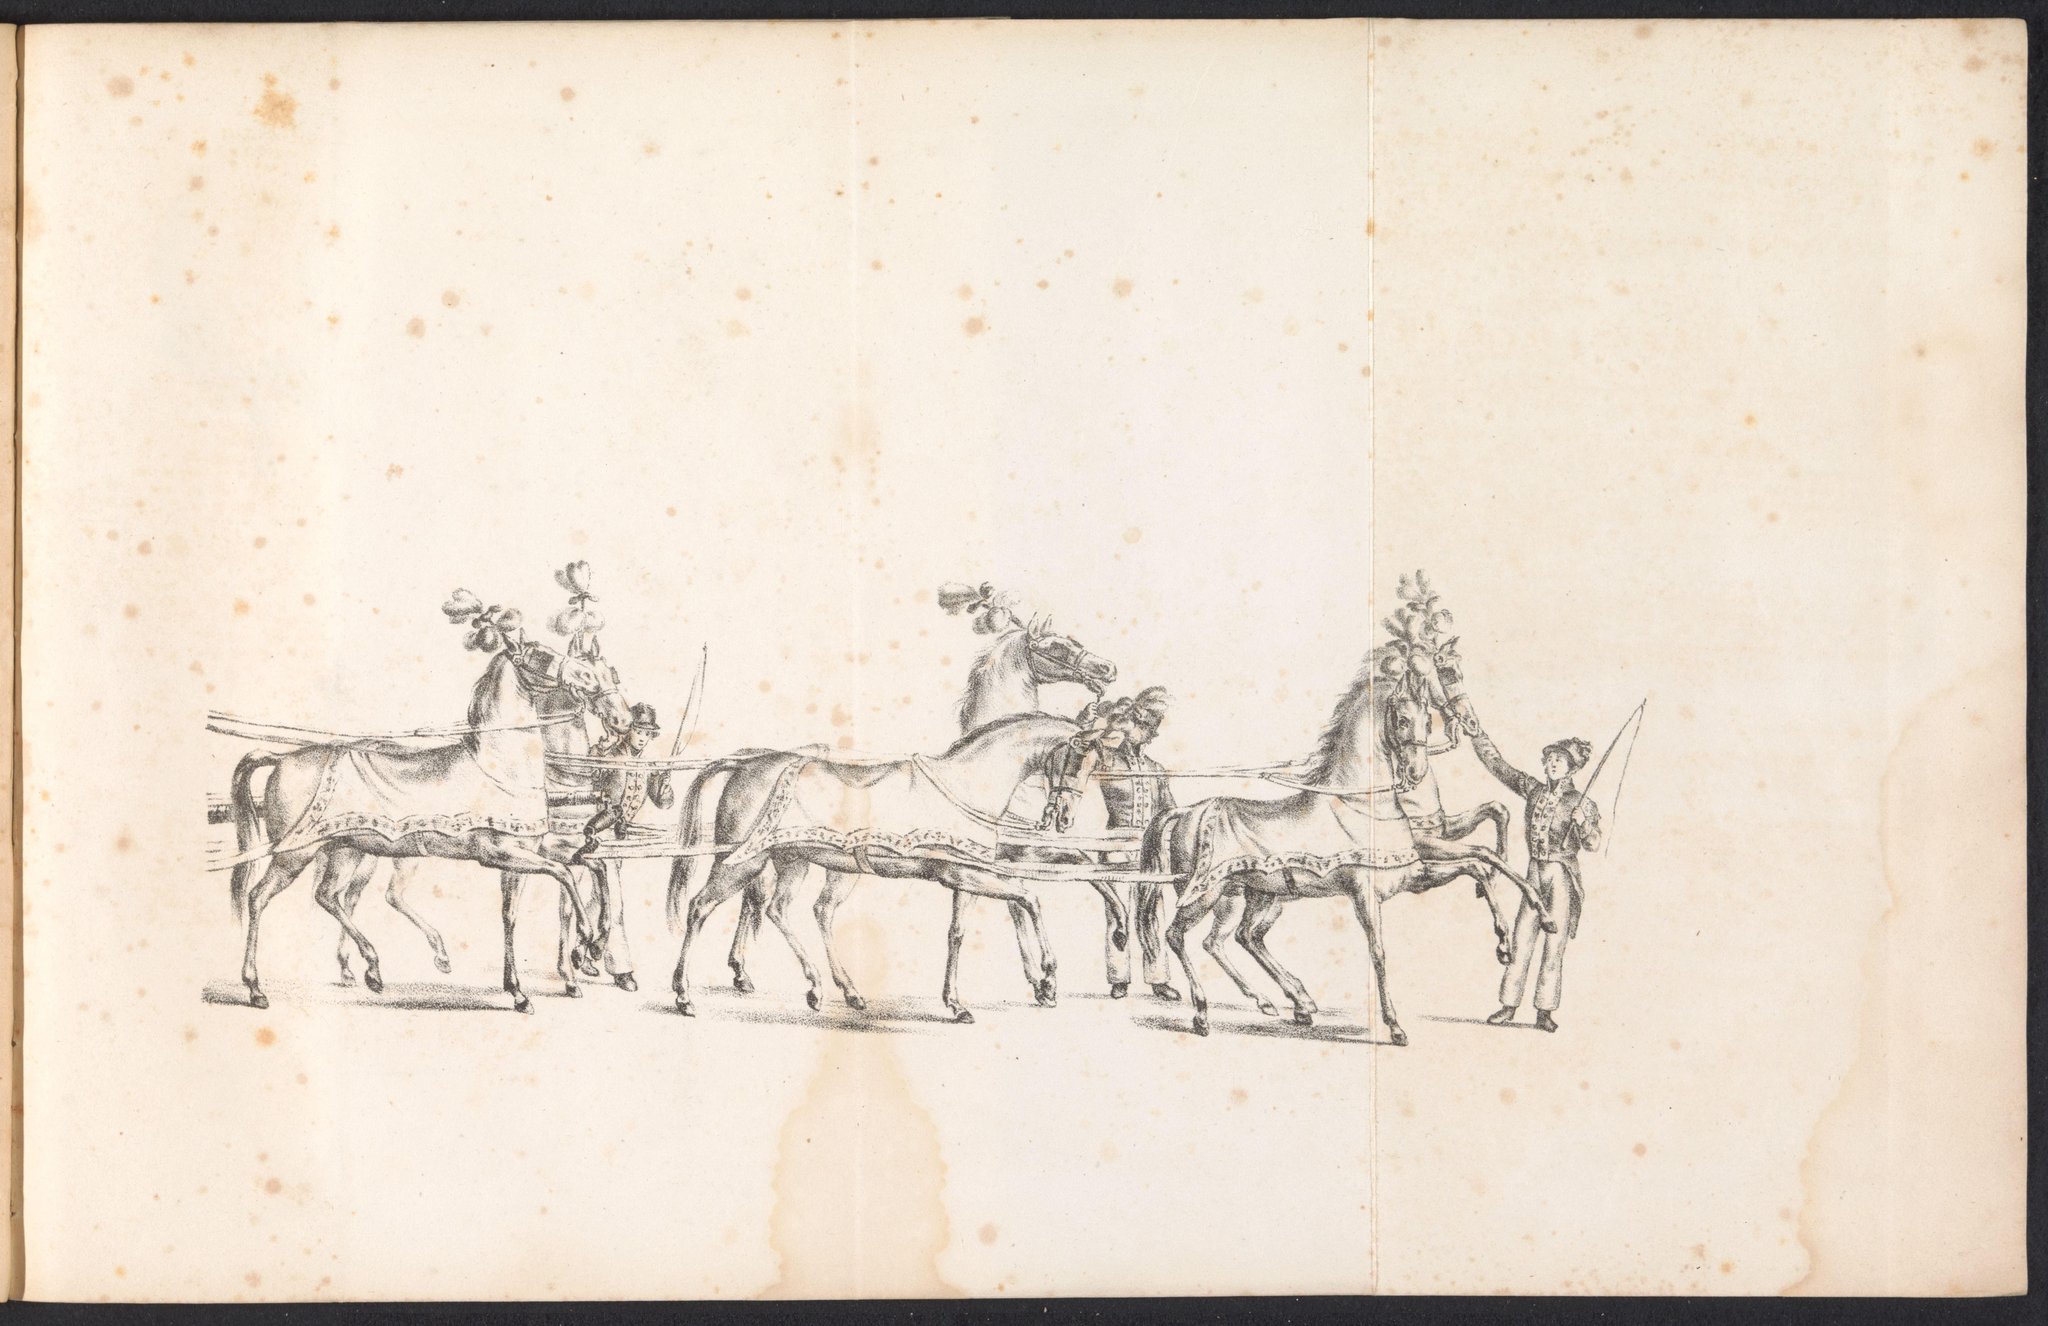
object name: print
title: Span van de eerste praalwagen in de optocht voor de Heilige Rombout, 1825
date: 1825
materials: paper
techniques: lithograph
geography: brussels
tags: rejoicing on special occasions (+ parade, pageant, cavalcade ~ festive activities), the hermit, martyr, and possibly former bishop of dublin, rum(b)old (rombaut) of malines; possible attributes: axe, hoe - post-mortem occurrences ~ male saint, procession ~ christian religion, mechelen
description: Span van zes paarden voor de eerste praalwagen in de ommegang voor de Heilige Rombout. De optocht werd gehouden op 28 juni, 5 en 12 juli 1825. Illustratie in een publicatie ter gelegenheid van de 1050-jarige viering in 1825 van de dood van de Heilige Rumoldus of Rombout, patroonheilige van de stad Mechelen, van wie werd gedacht dat hij in 775 was overleden.